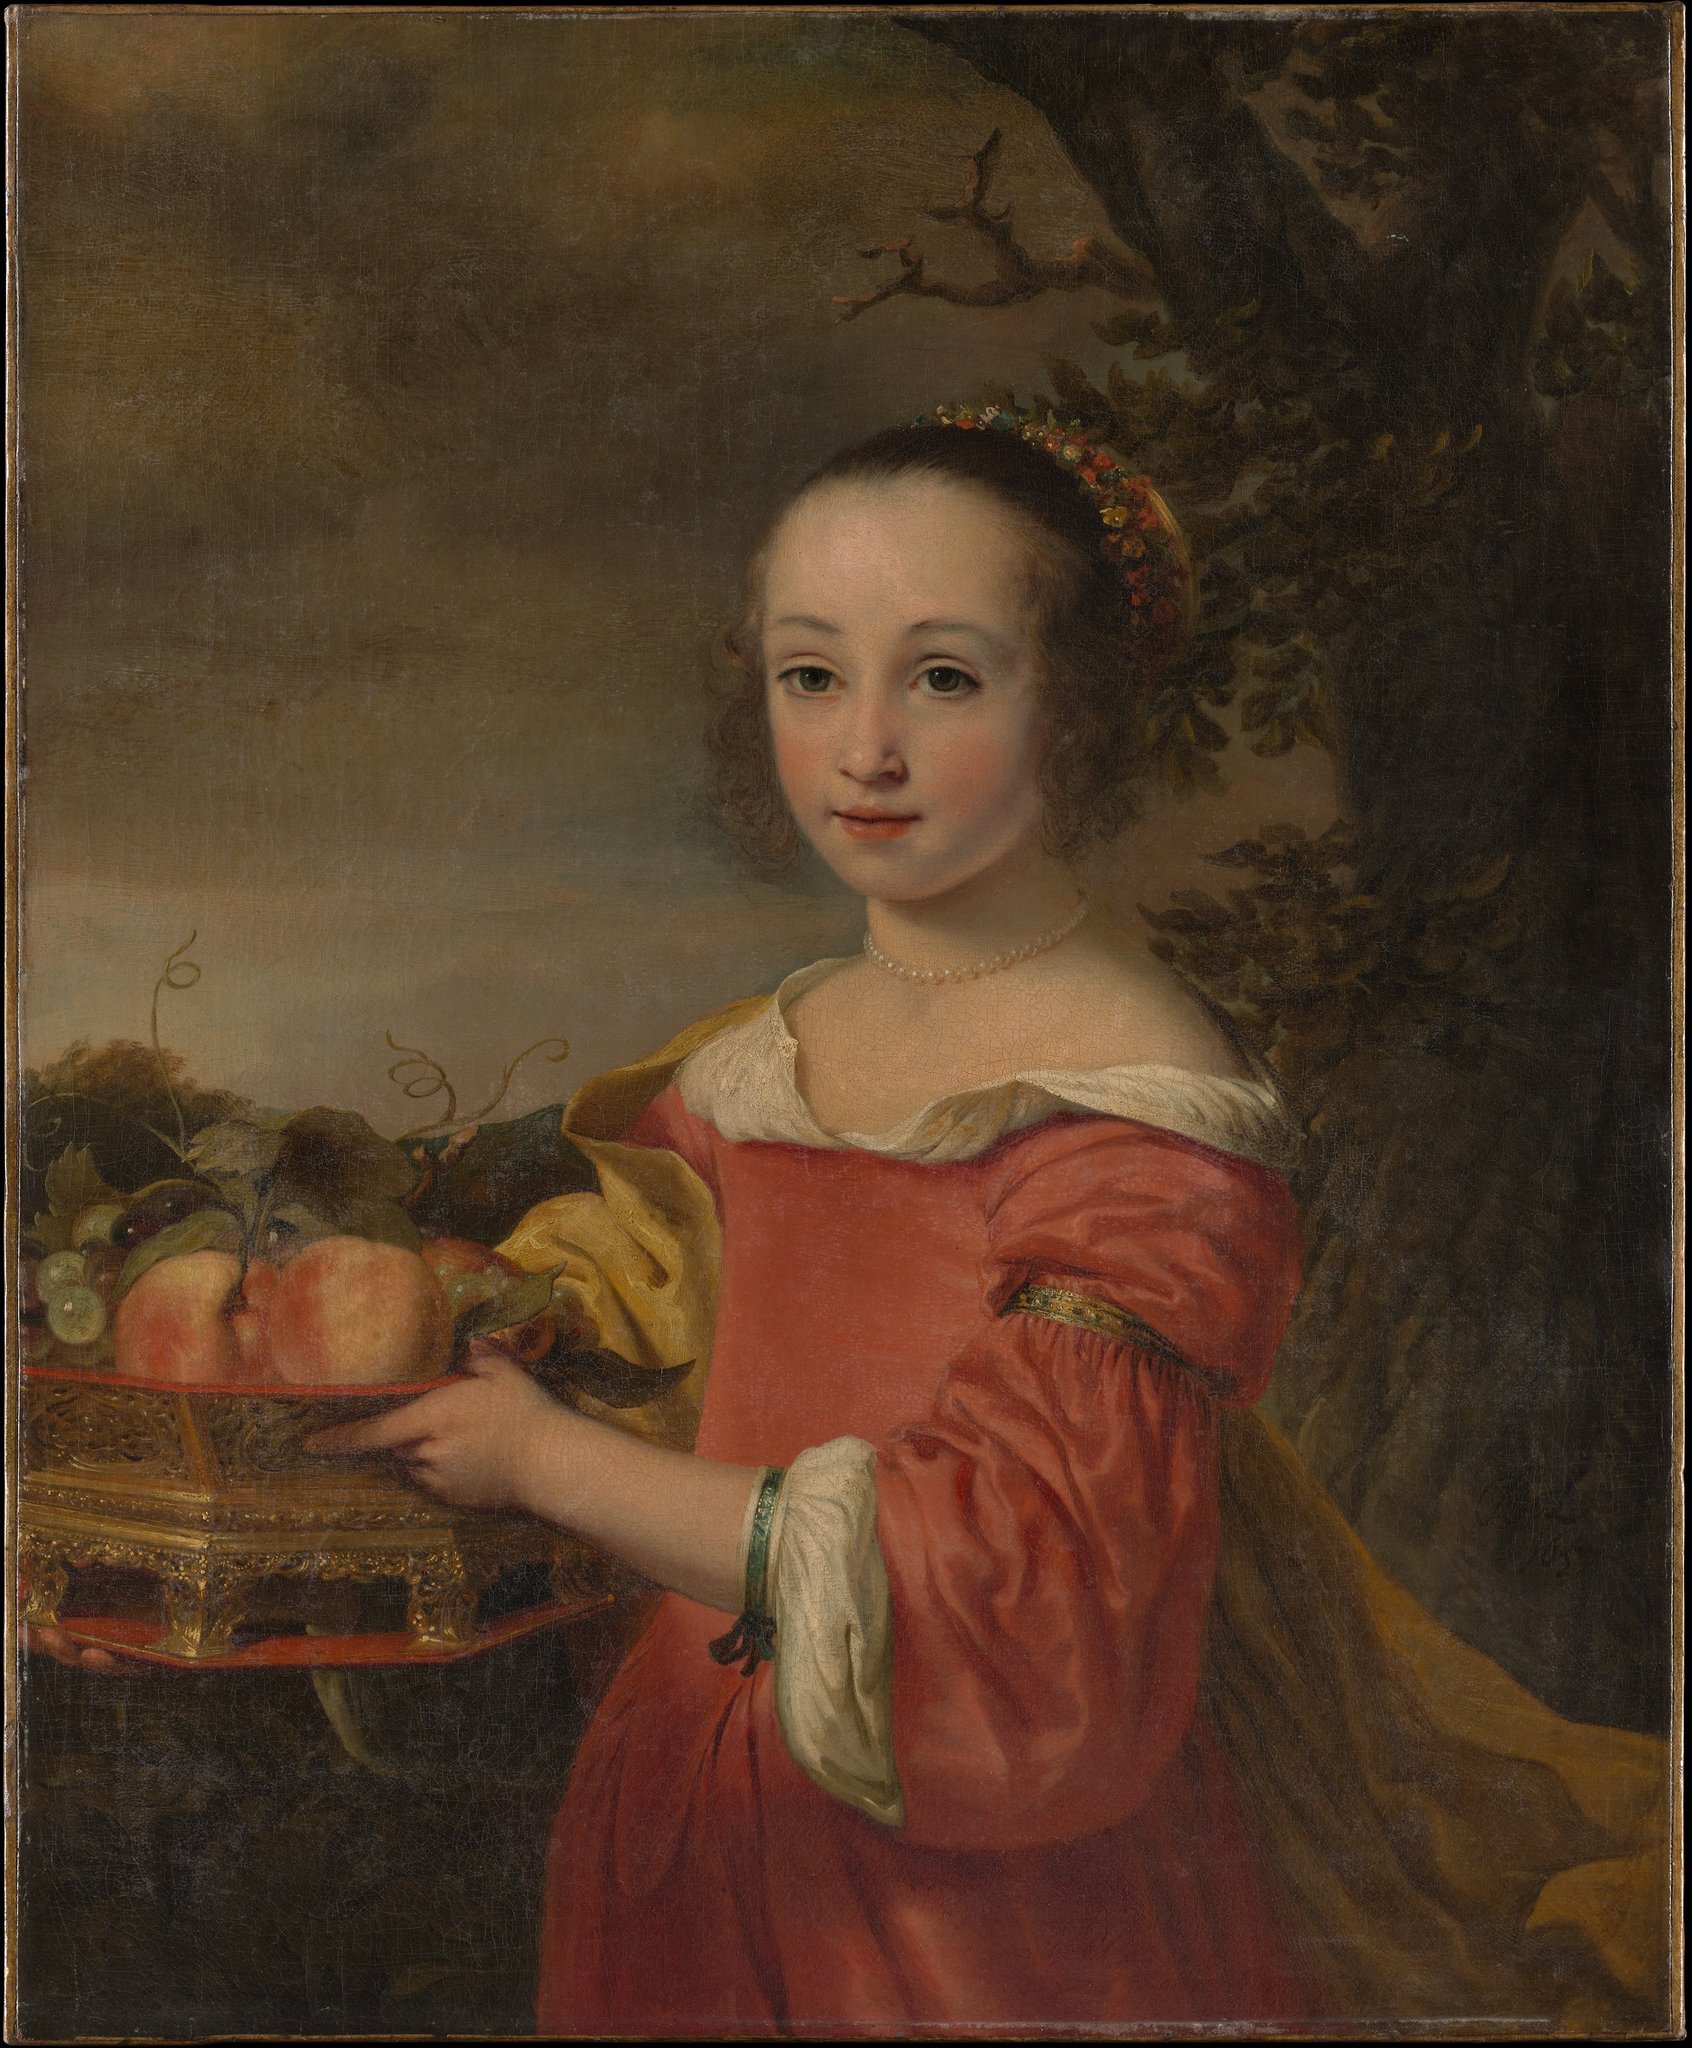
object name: painting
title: Petronella Elias (1648–1667) with a Basket of Fruit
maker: ferdinand bol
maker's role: artist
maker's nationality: dutch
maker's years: 1616-1680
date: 1657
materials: canvas, oil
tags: fruit,girls,portraits